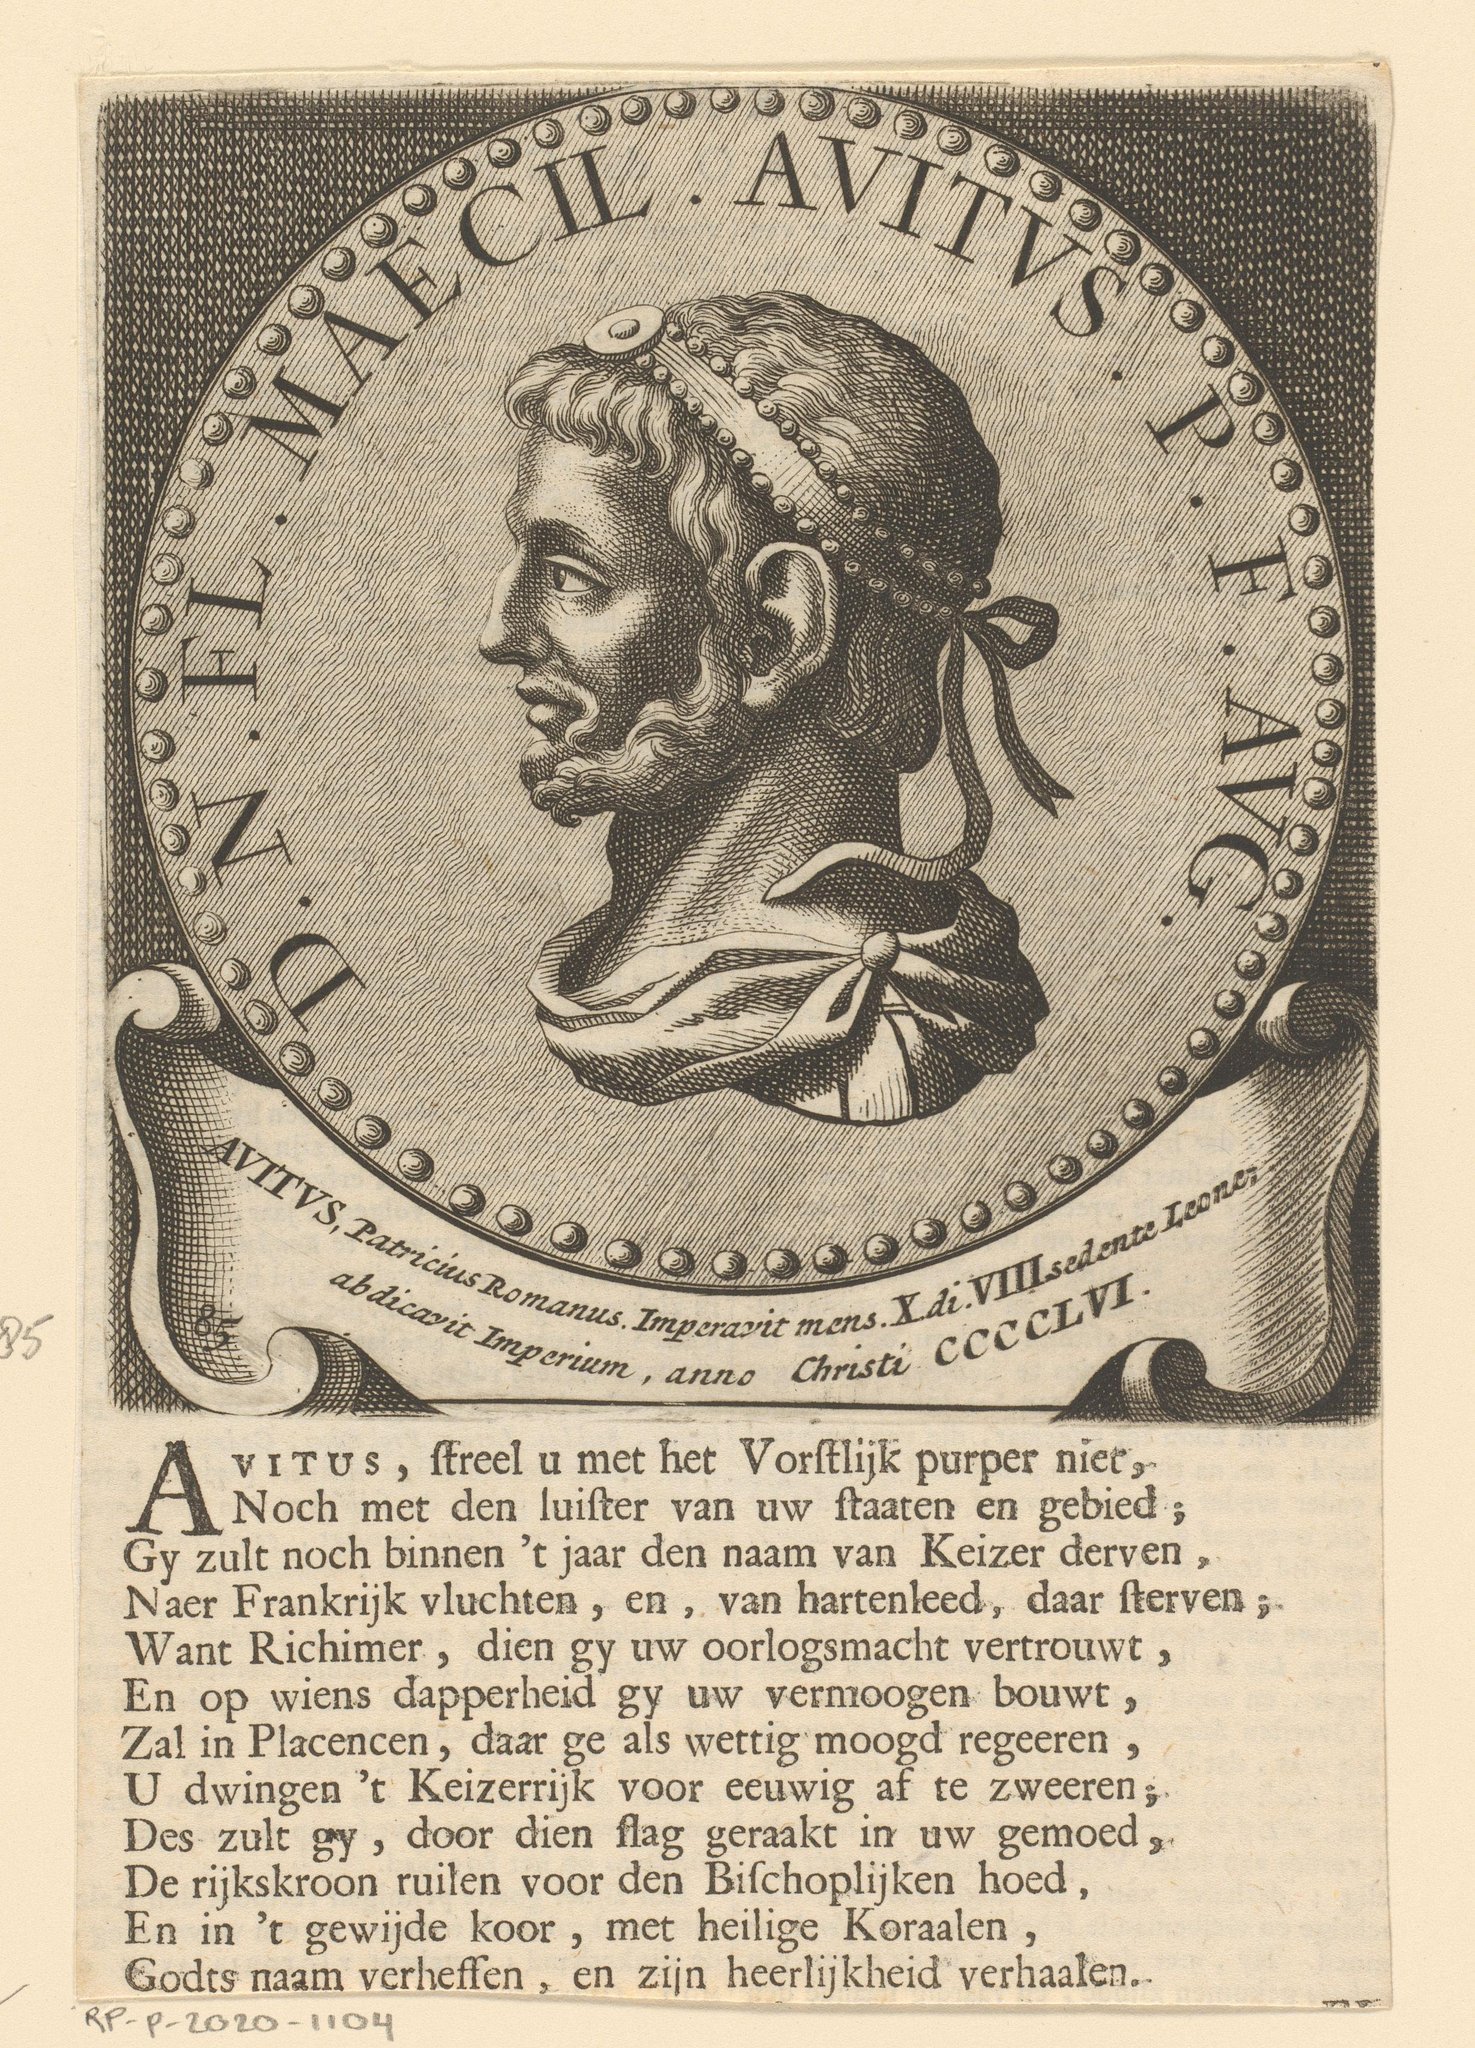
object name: book illustration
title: Avitus, patricius Romanus (...)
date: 1697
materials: paper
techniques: engraving, etching, letterpress printing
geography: utrecht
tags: historical persons, emperor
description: Prent uit: Bogaert, Abraham. De Roomsche monarchy, vertoont in de muntbeelden der westersche en oostersche keizeren (...). Utrecht: François Halma en Willem van de Water, 1697, p. 277. Eerste staat verschenen in een grotere prent met twaalf portretten, gedateerd 1695.